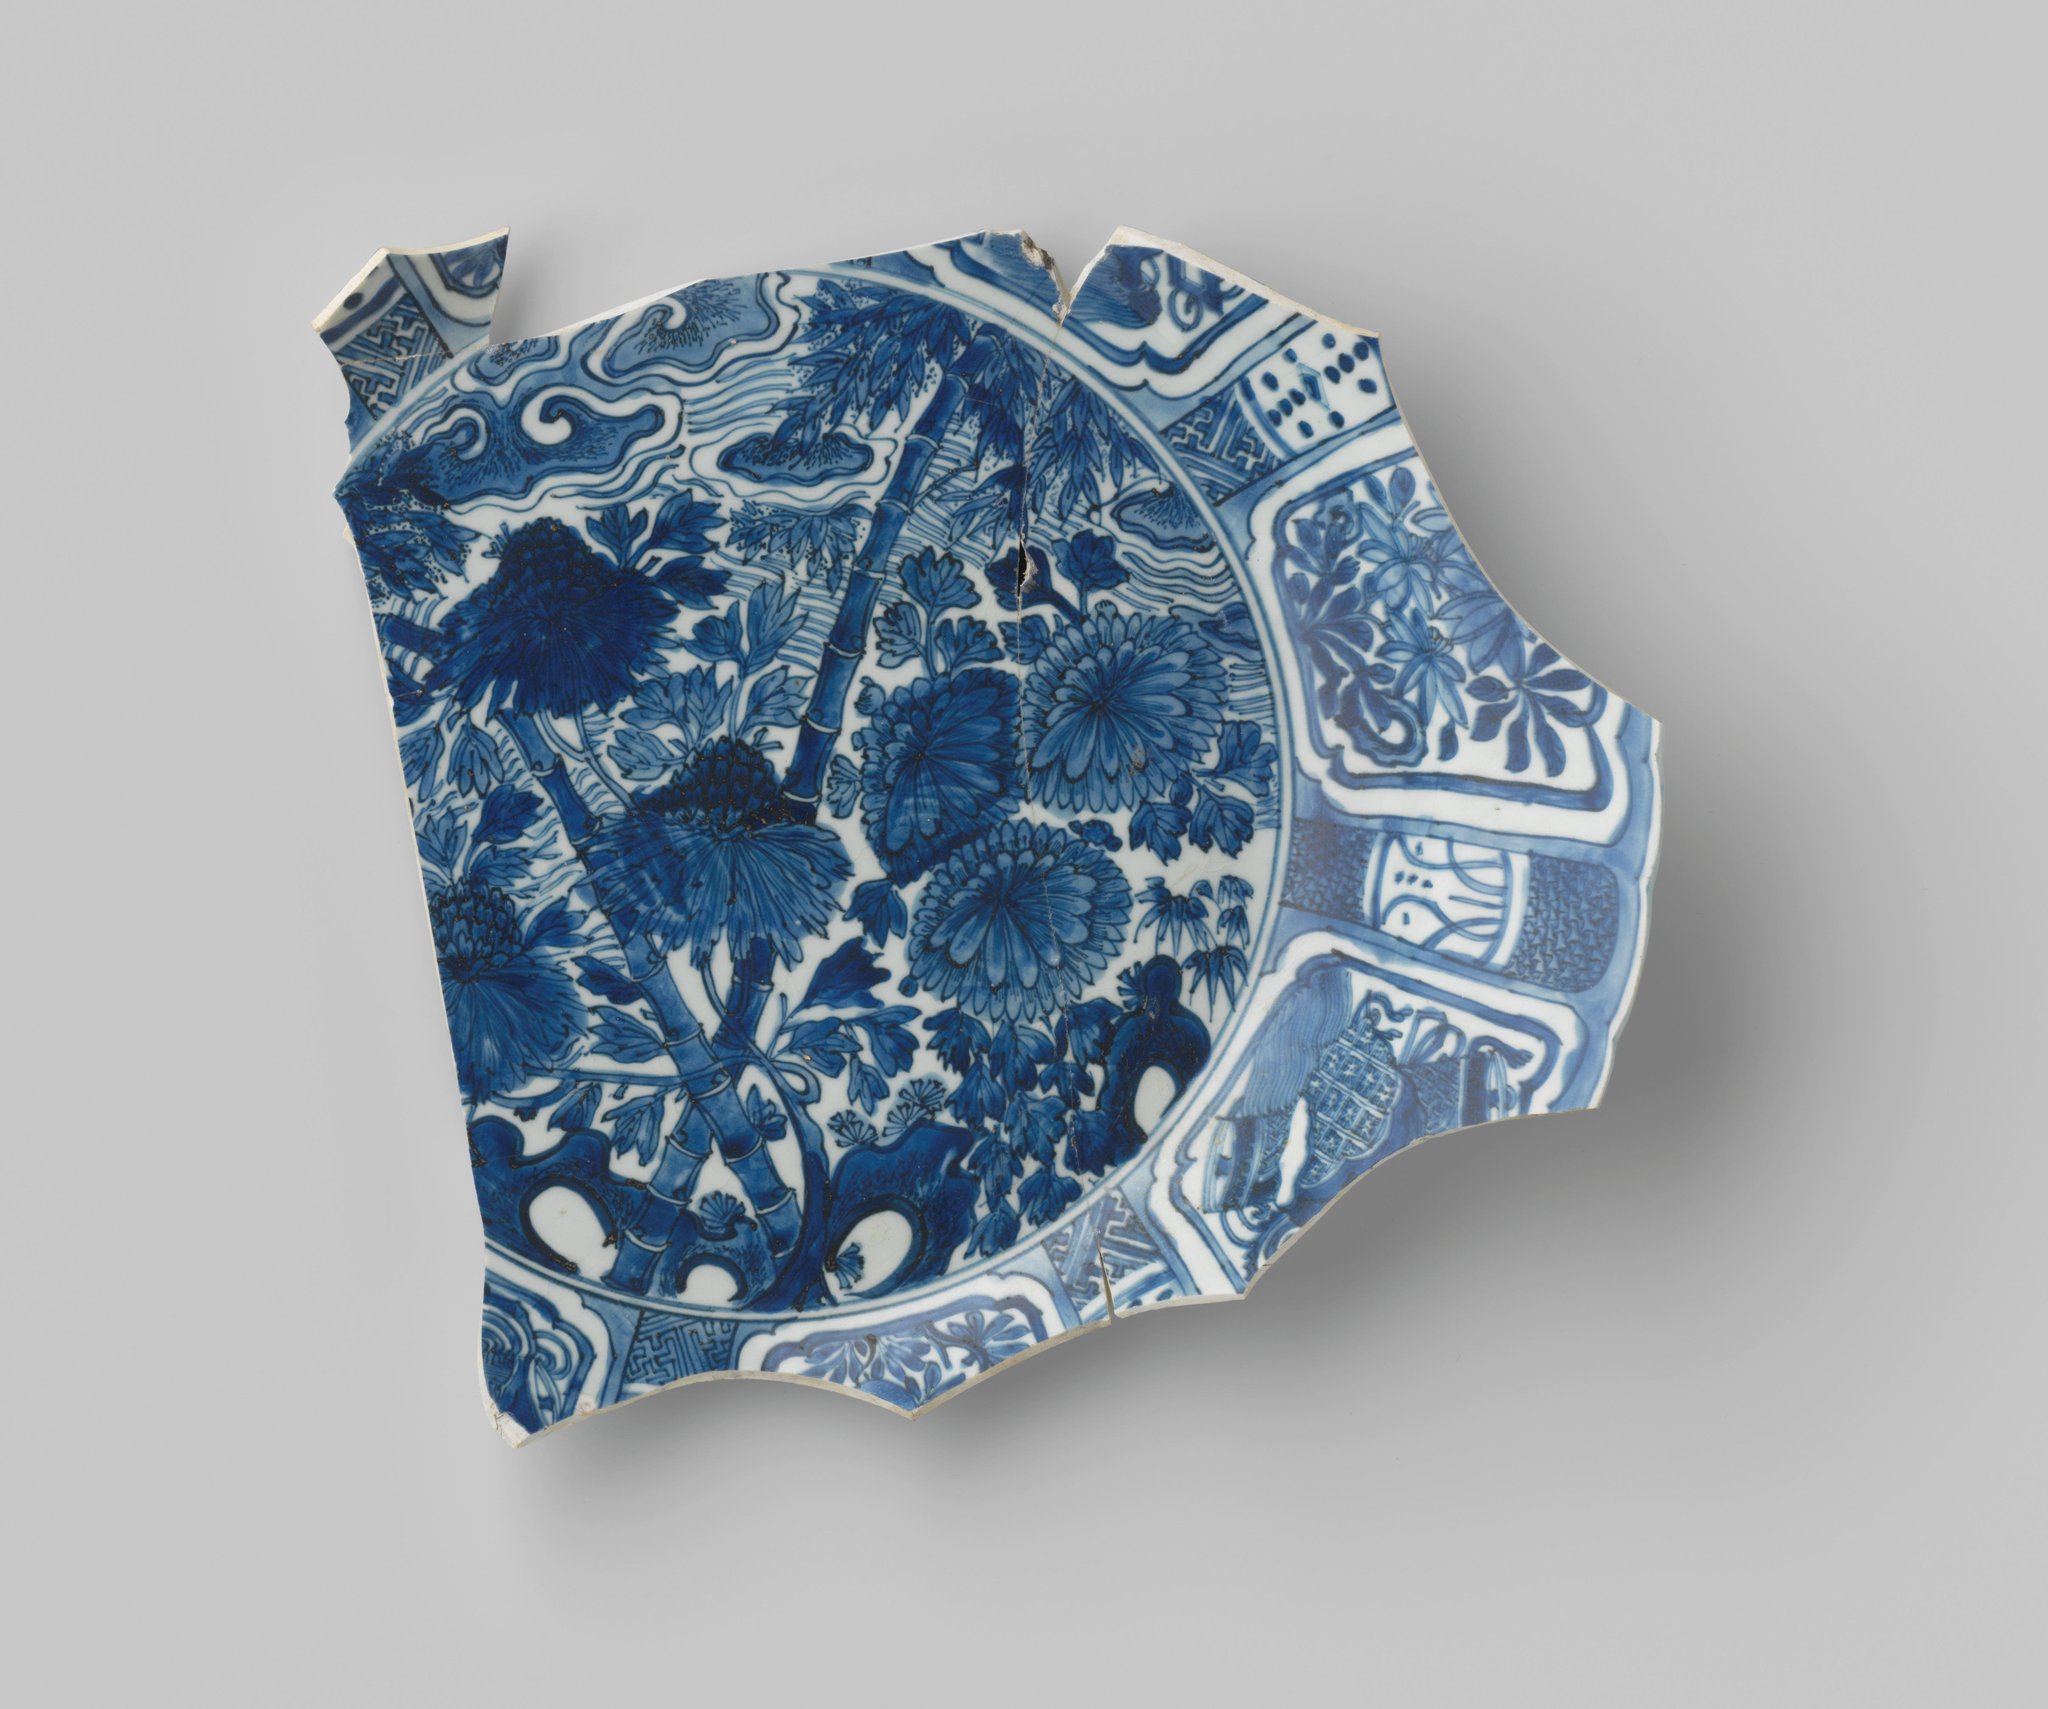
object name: platter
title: Fragment schotel uit V.O.C.-schip de 'Witte Leeuw'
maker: Anonymous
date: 1613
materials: bone china, glaze, porcelain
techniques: painted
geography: jingdezhen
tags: verenigde oostindische compagnie, sint-helena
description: A large plate with a flattened rim. A scalloped medallion with rui heads within concentric bands filled with alternating diaper patterns. A central decoration of chrysanthemums, peonies and bamboo with rocks. Panels decorated with flowers, fruits and symbols.